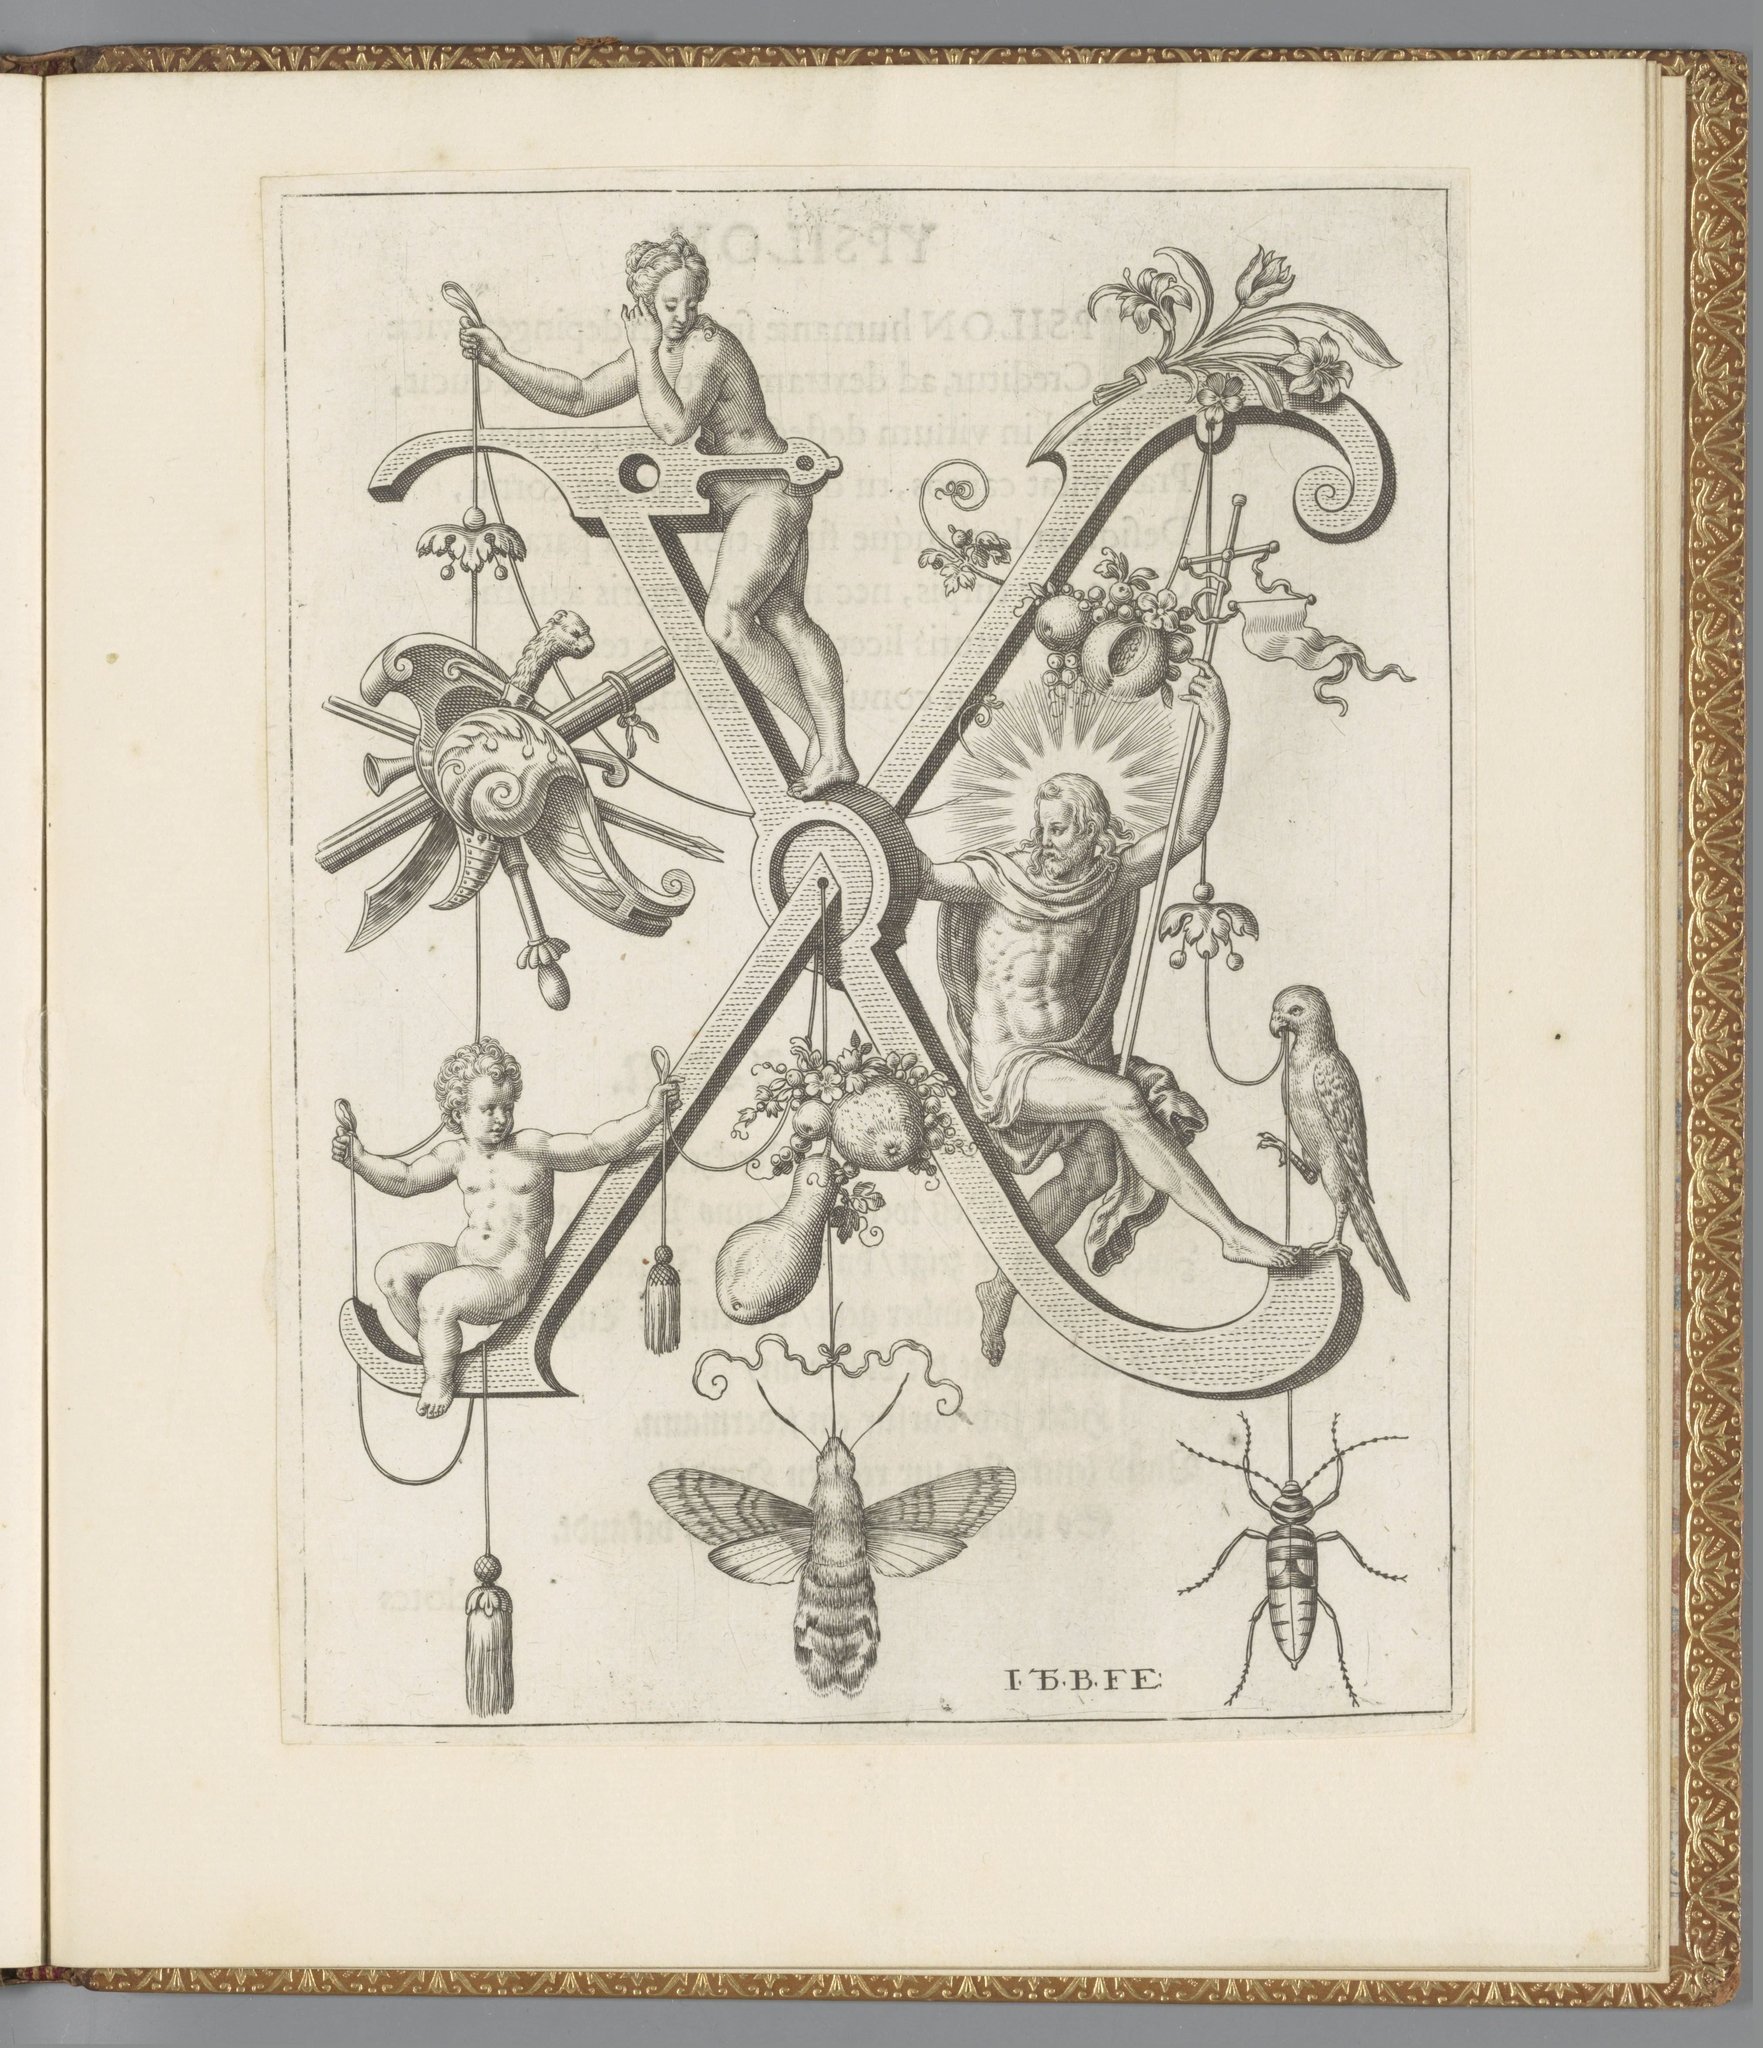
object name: album leaf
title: Nova Alphati Effictio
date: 1595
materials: paper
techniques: engraving, letterpress printing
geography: frankfurt am main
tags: fruits and vegetables ~ ornament, letters, alphabet, script, christ as adult, insects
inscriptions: collector's mark: Lugt 2760, collector's mark: Lugt 2228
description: Ornamentele letter X met Christus met kruisstaf en banier. Linksboven een naakte vrouw. De letter is verder versierd met een trofee, insecten, bloemen, trossen vruchten en vogel. Op verso verzen in het Latijn en het Duits. Prent maakt deel uit van een album.